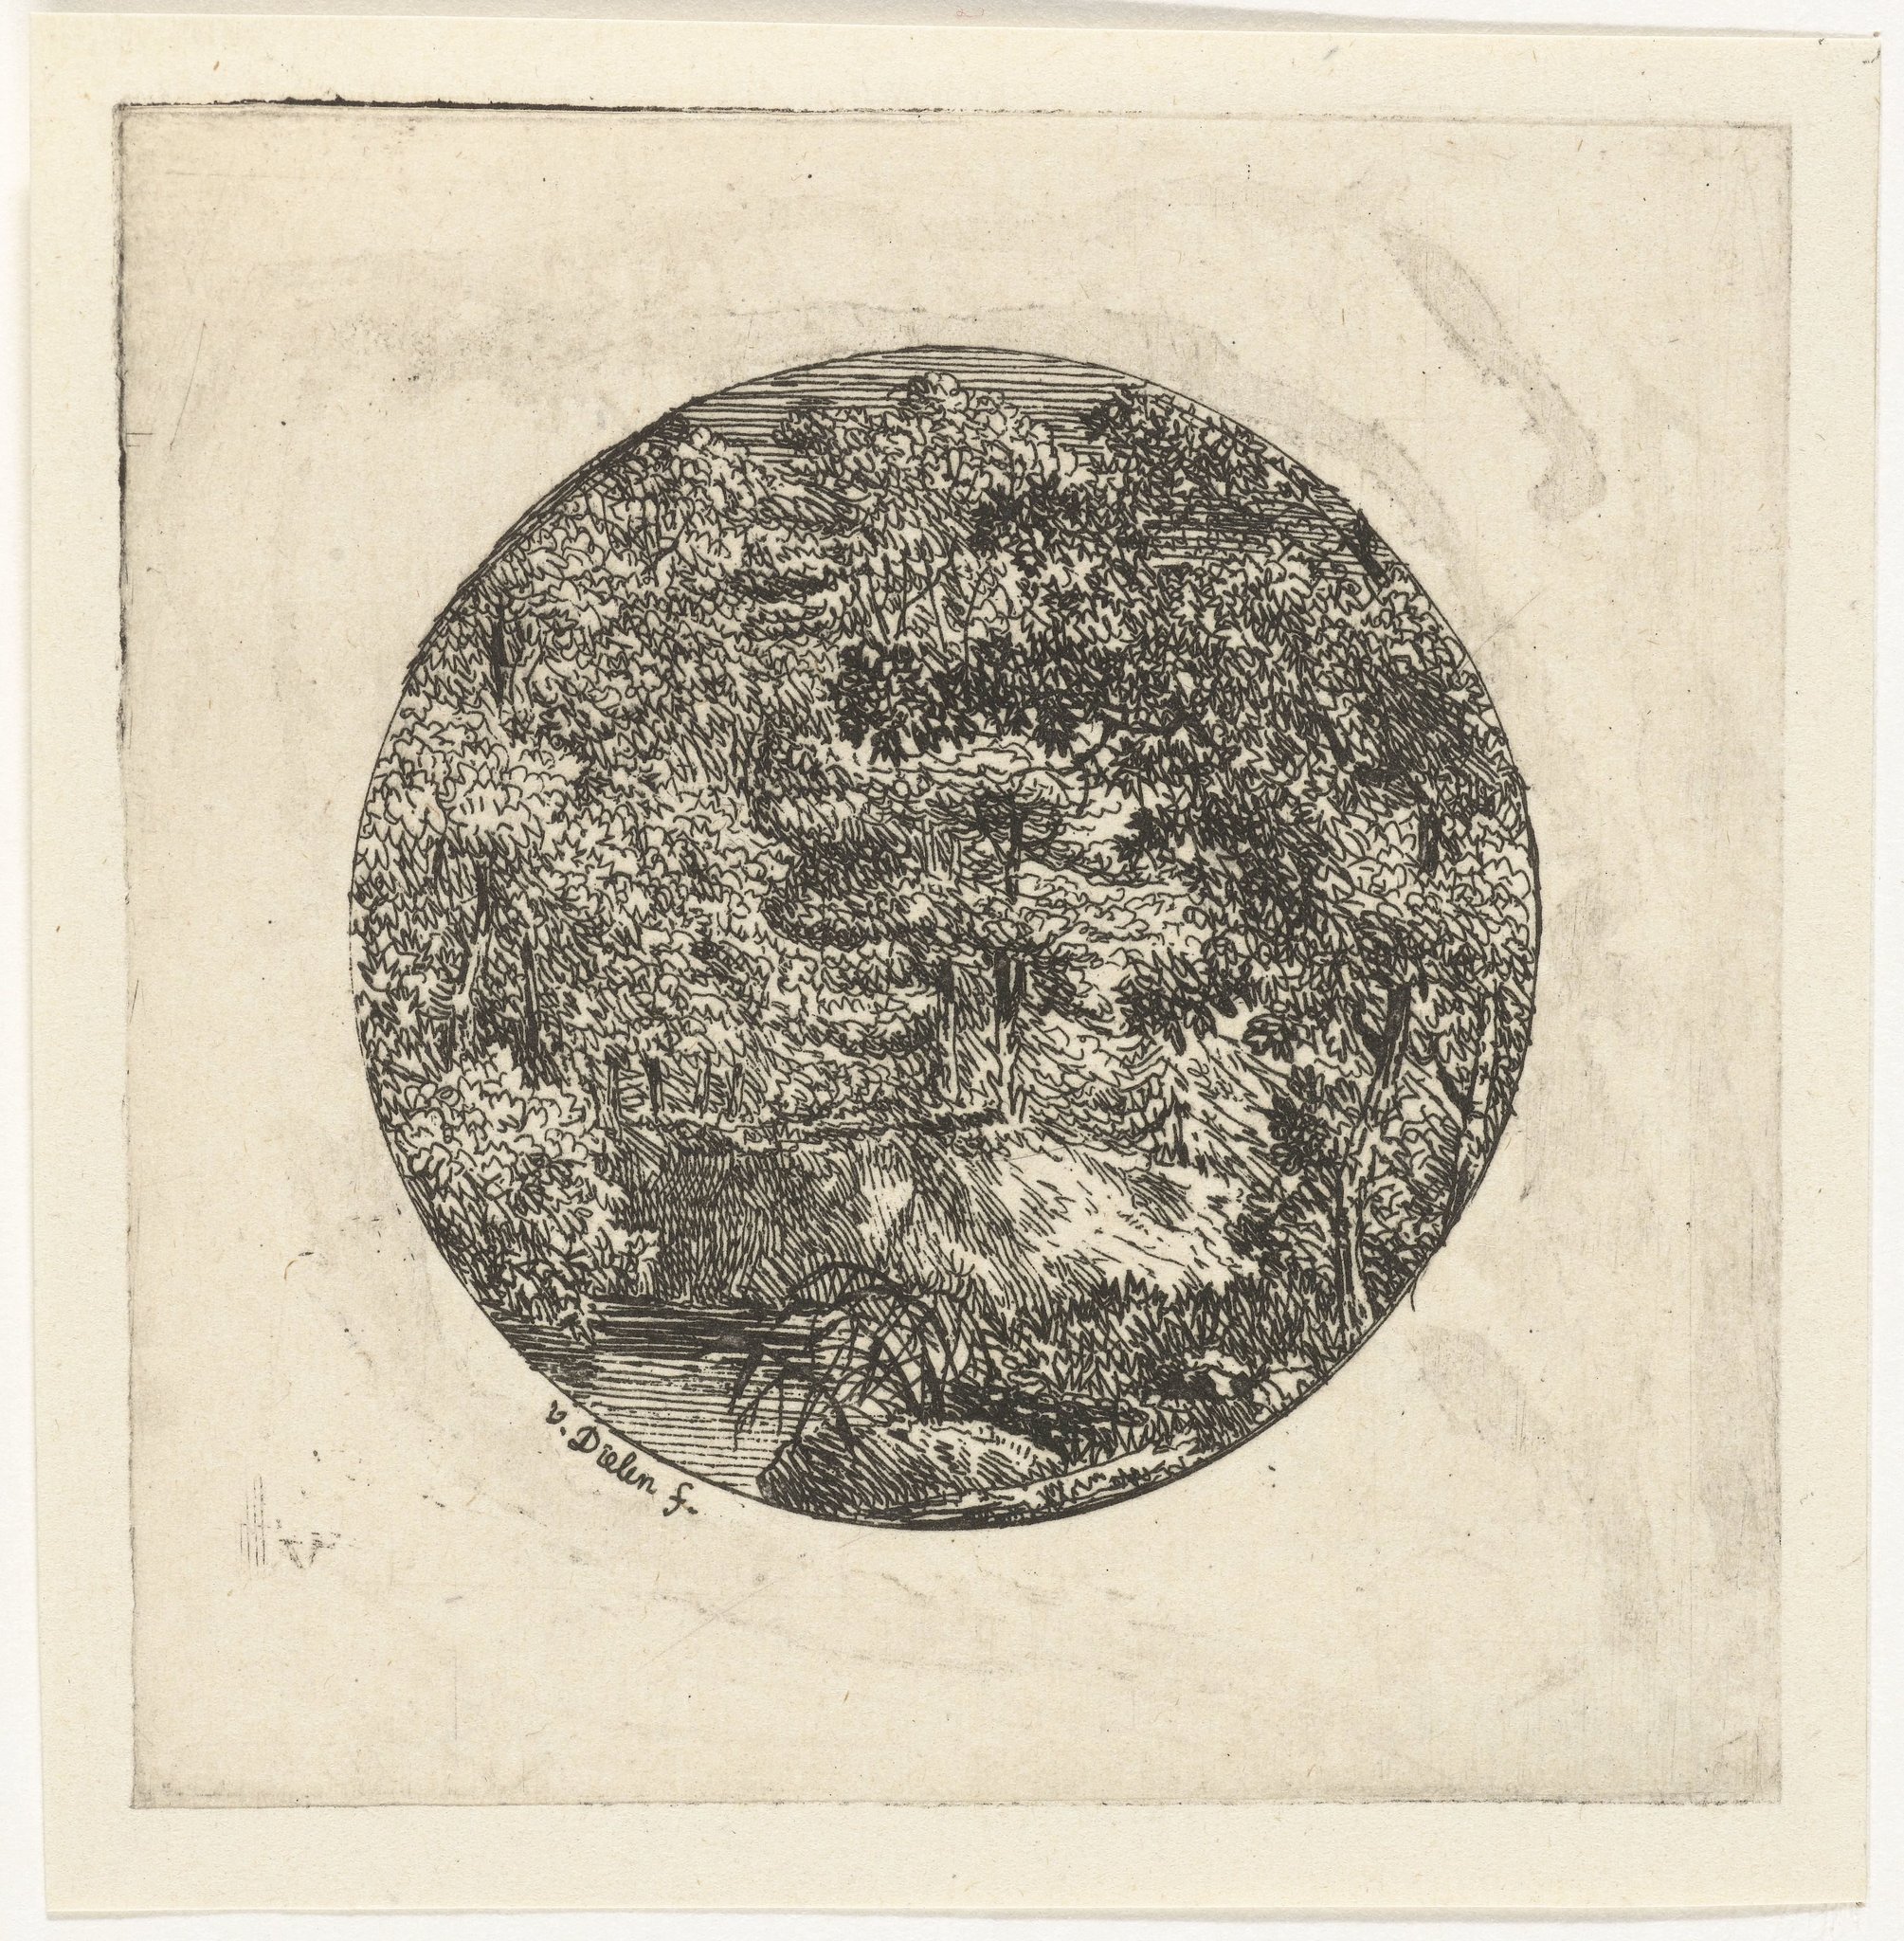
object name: print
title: Boslandschap in rond kader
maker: adriaan jacob willem van dielen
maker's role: print maker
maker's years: 1772-1812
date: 1782-1812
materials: paper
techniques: etching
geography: netherlands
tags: forest, wood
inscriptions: collector's mark: Lugt 2228